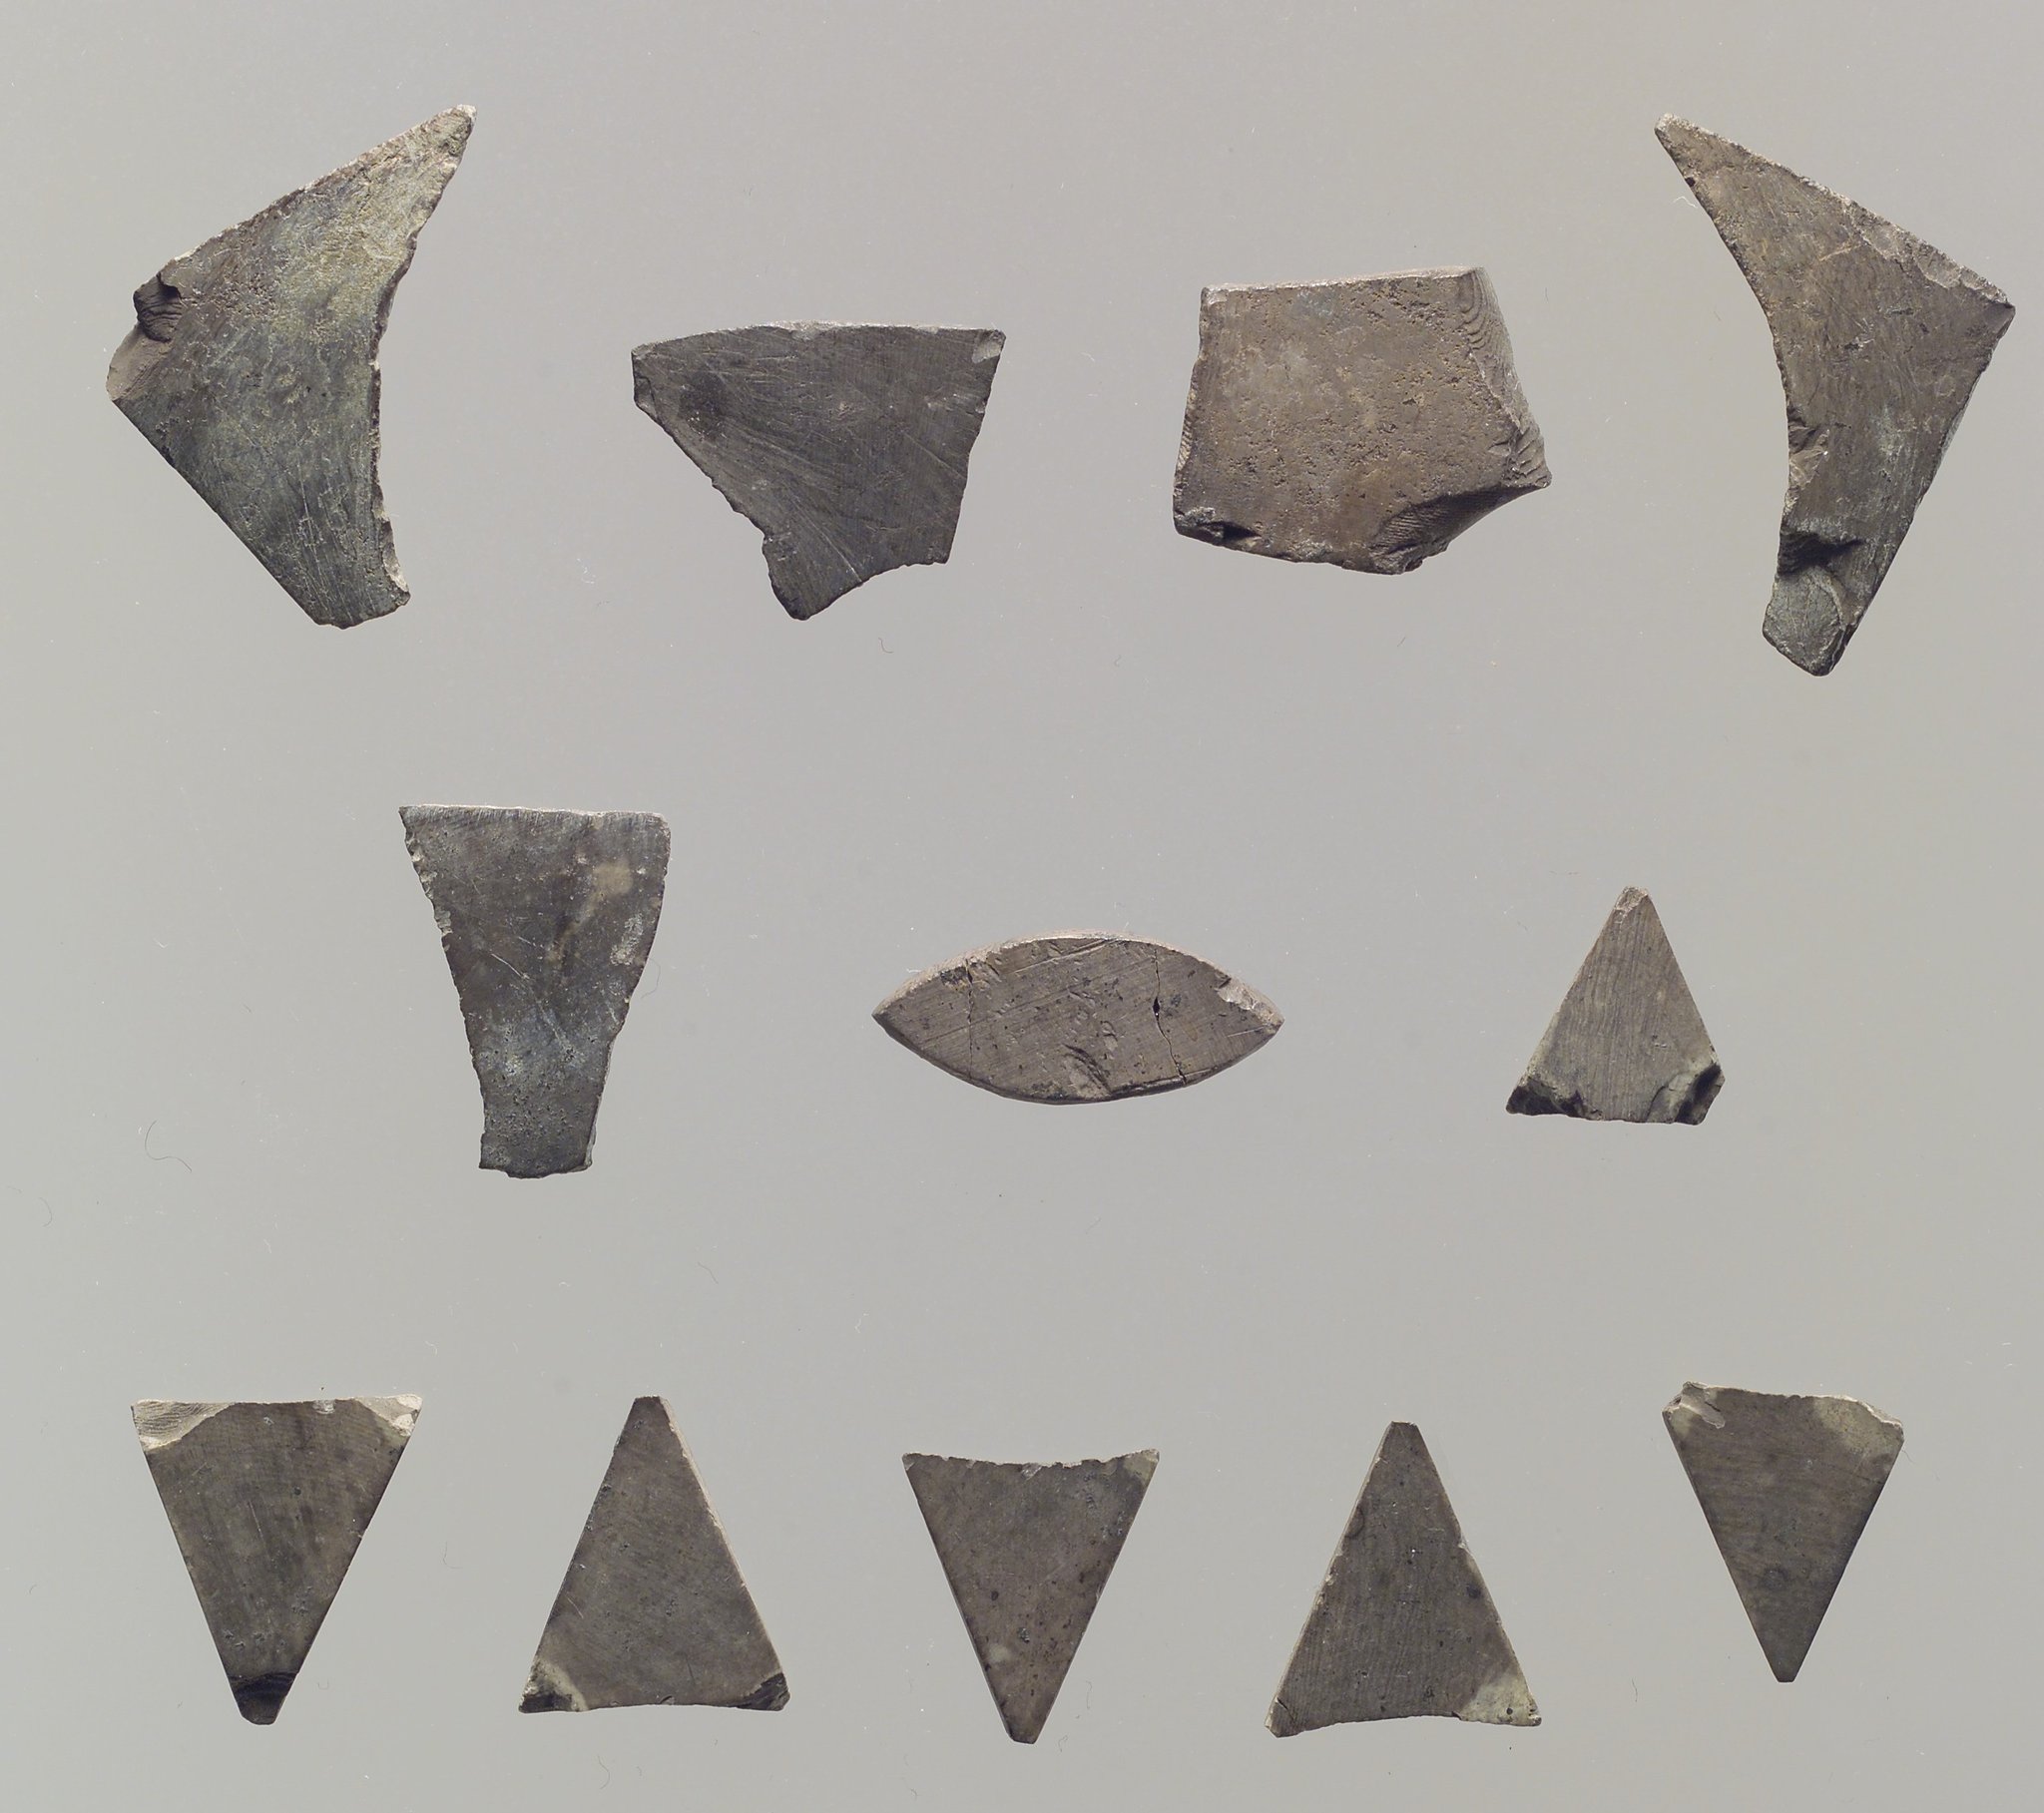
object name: furniture element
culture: assyrian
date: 1800-1701 BCE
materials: ivory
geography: anatolia